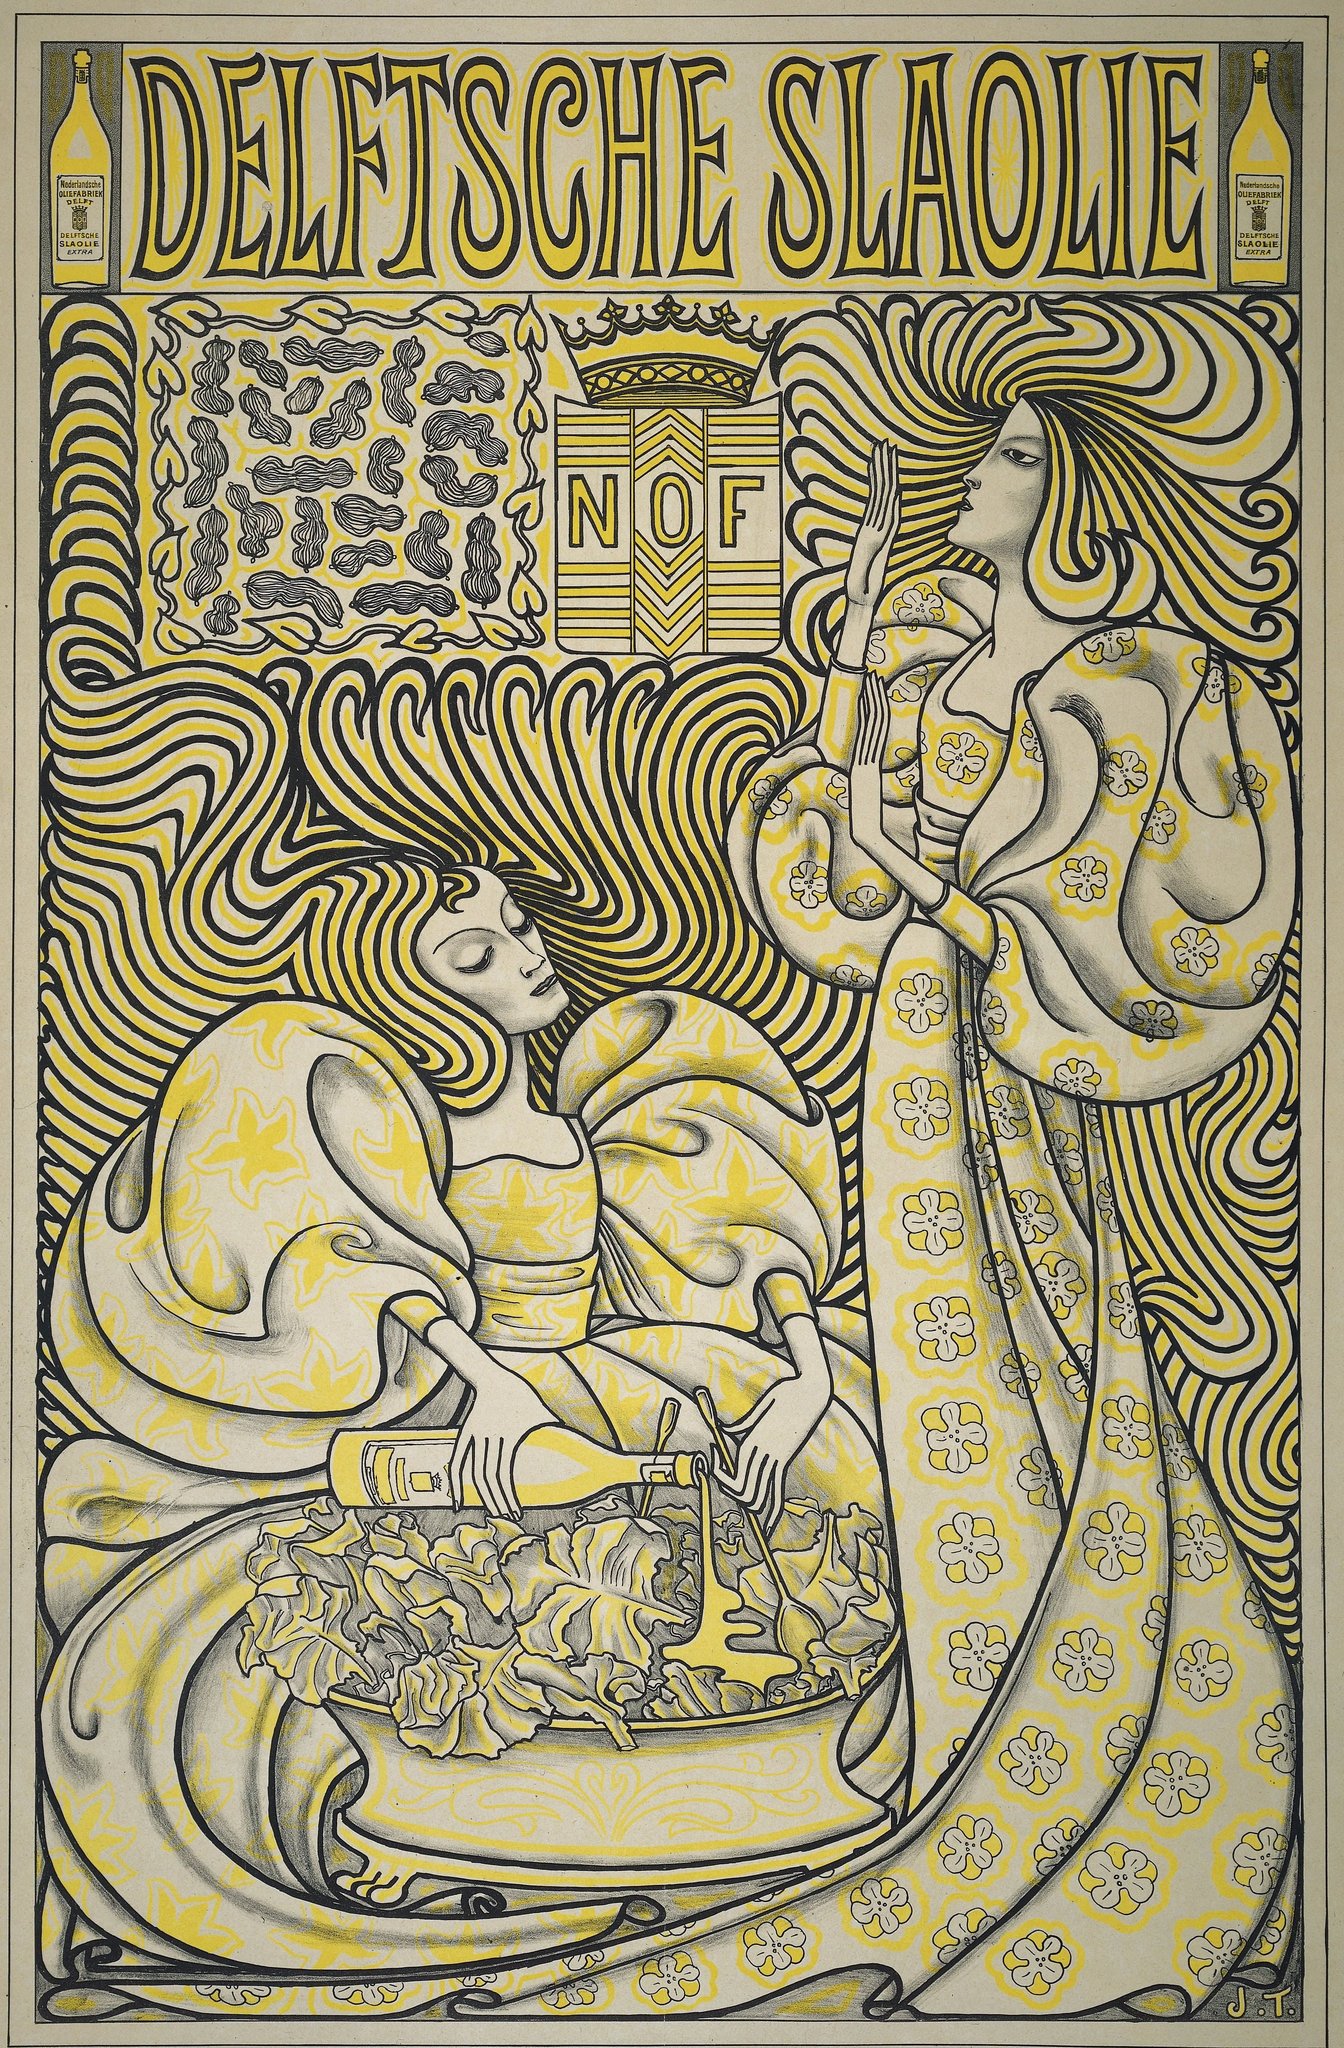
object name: poster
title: Poster for Delft Salad Oil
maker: jan toorop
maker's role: draughtsman, painter, print maker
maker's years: 1858-1928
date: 1894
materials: paper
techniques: lithograph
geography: netherlands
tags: hair, preparation of food, oils and vegetable fats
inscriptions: monogram: ‘J.T.’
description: This poster was commissioned by the Nederlandsche Oliefabriek, an oil manufacturer in Delft. Two women with wavy hair and billowing draperies occupy most of the composition. One of them is dressing a salad. The women with their emphatic contours draw attention away from the actual advertisement, namely for the salad oil. The poster became an icon and lent Dutch Art Nouveau its nickname, the ‘salad oil style’.